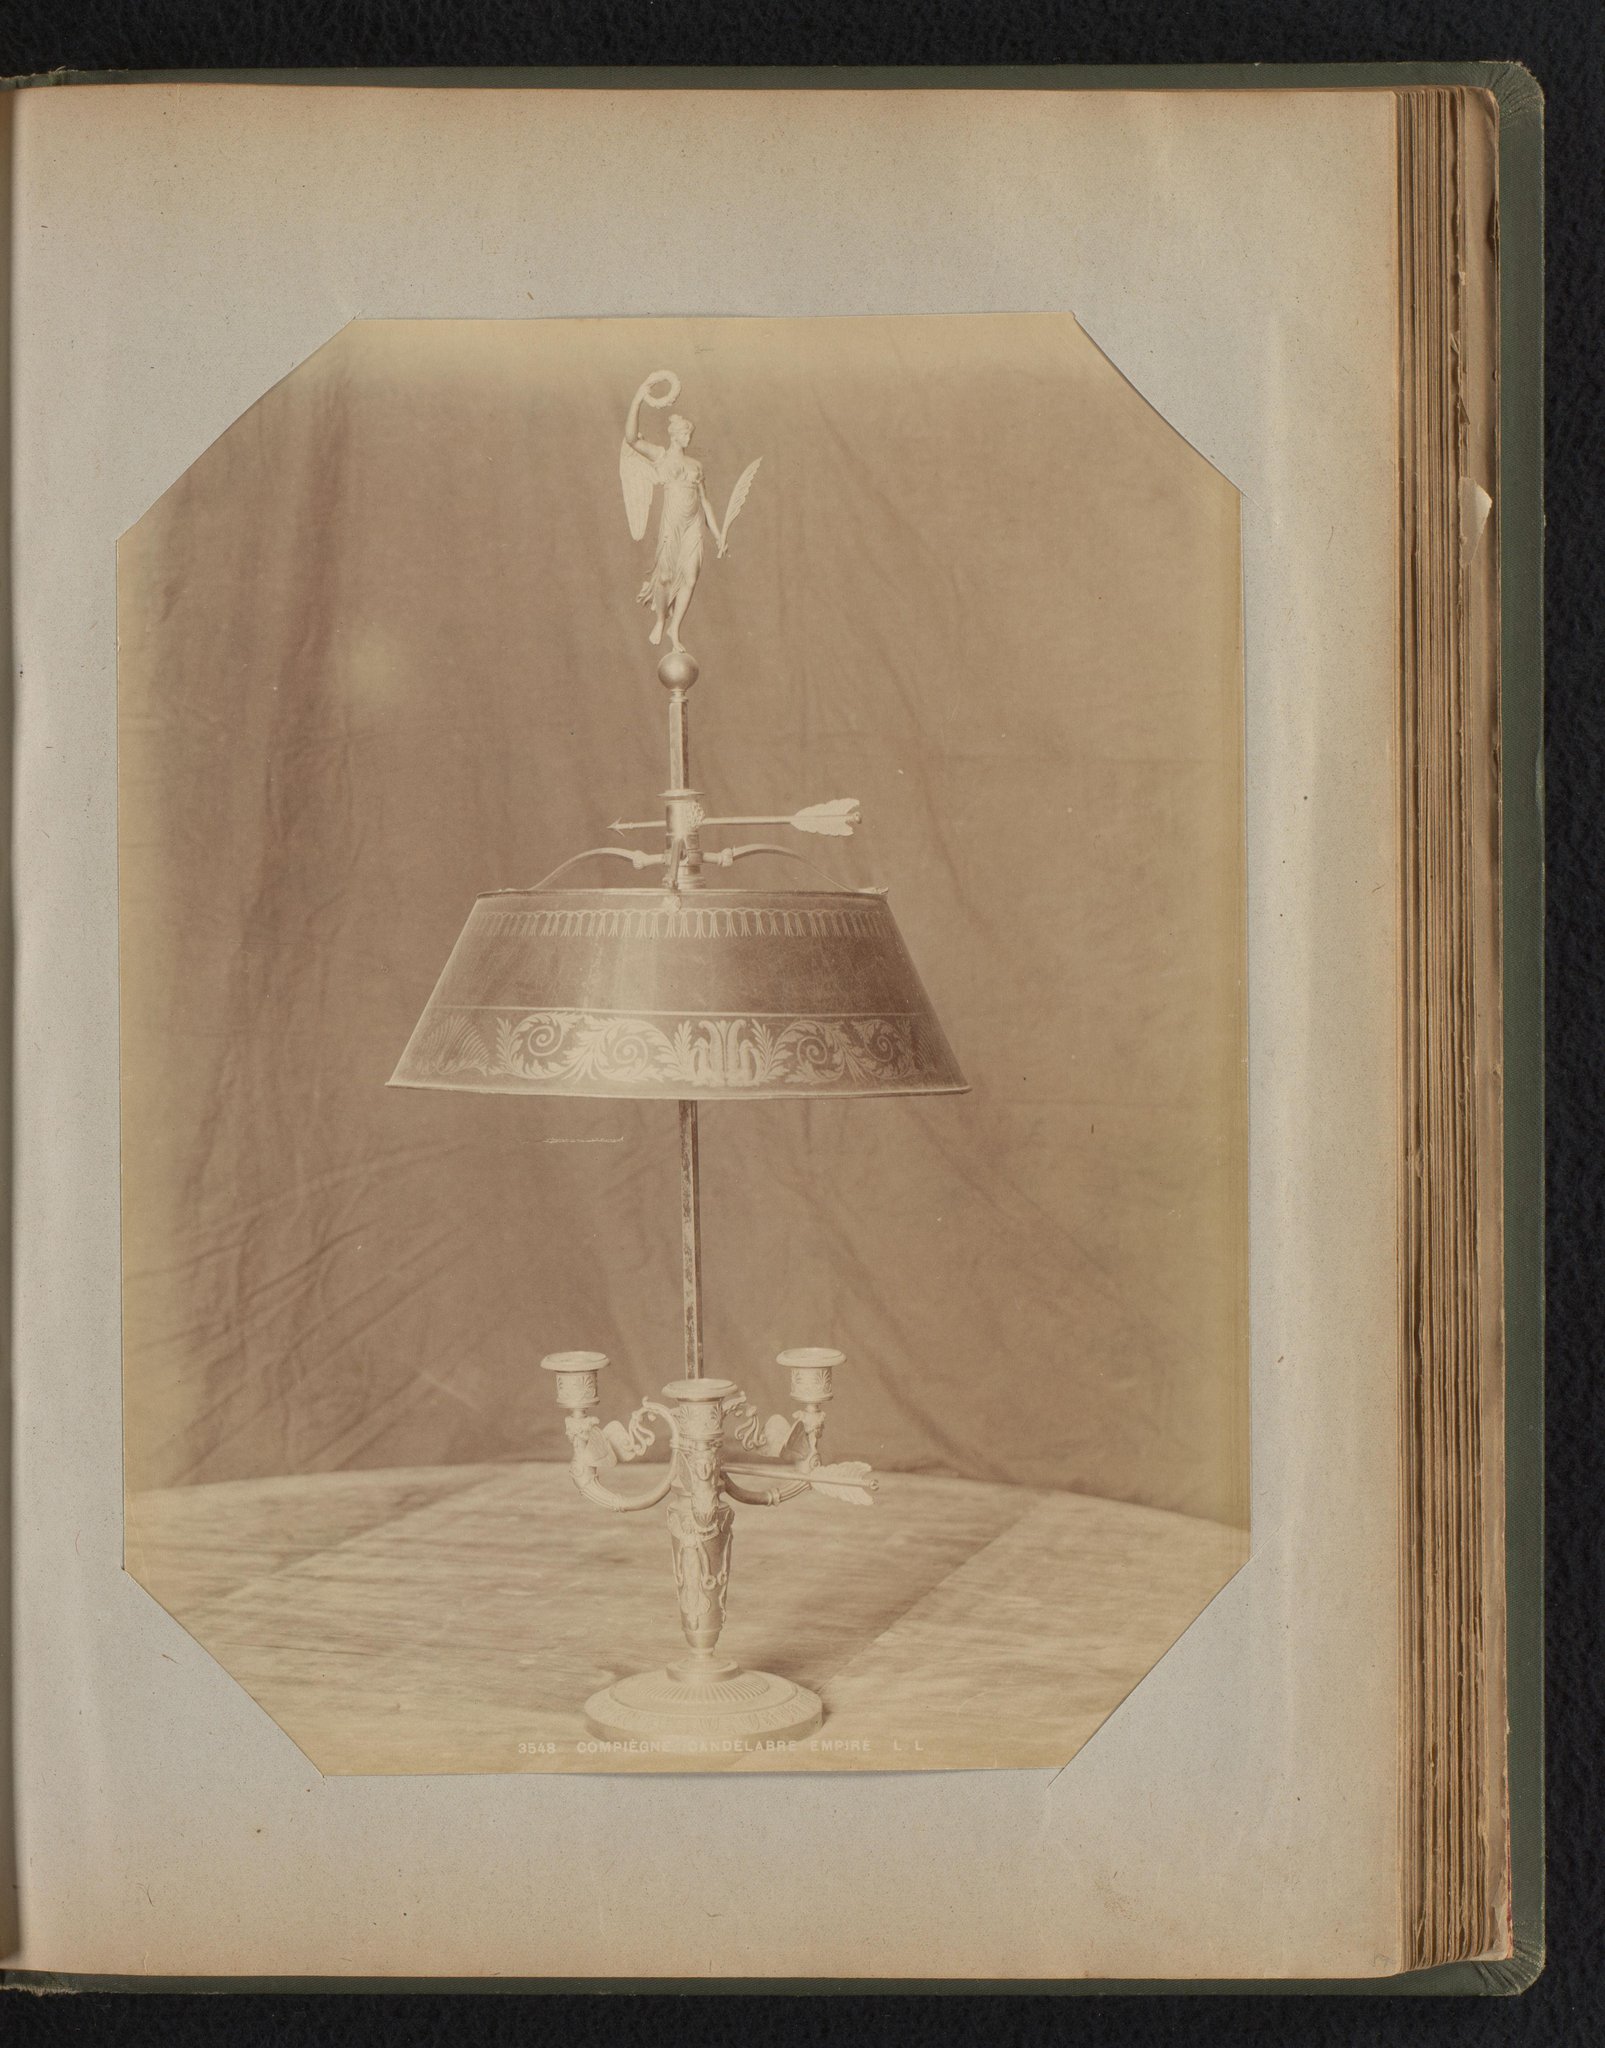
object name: photograph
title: Driearmige bronzen kandelaar afgedekt met een kap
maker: Anonymous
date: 1860-1900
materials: paper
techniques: albumen print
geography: france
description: Kandelaar is gedecoreerd met twee pijlen en bovenop een vrouwelijk gestalte met vleugels en lauwerkrans. Onderdeel van een serie met betrekking tot het interieur van het paleis van Versailles met kroonluchters, deuren, portalen en meubelstukken.